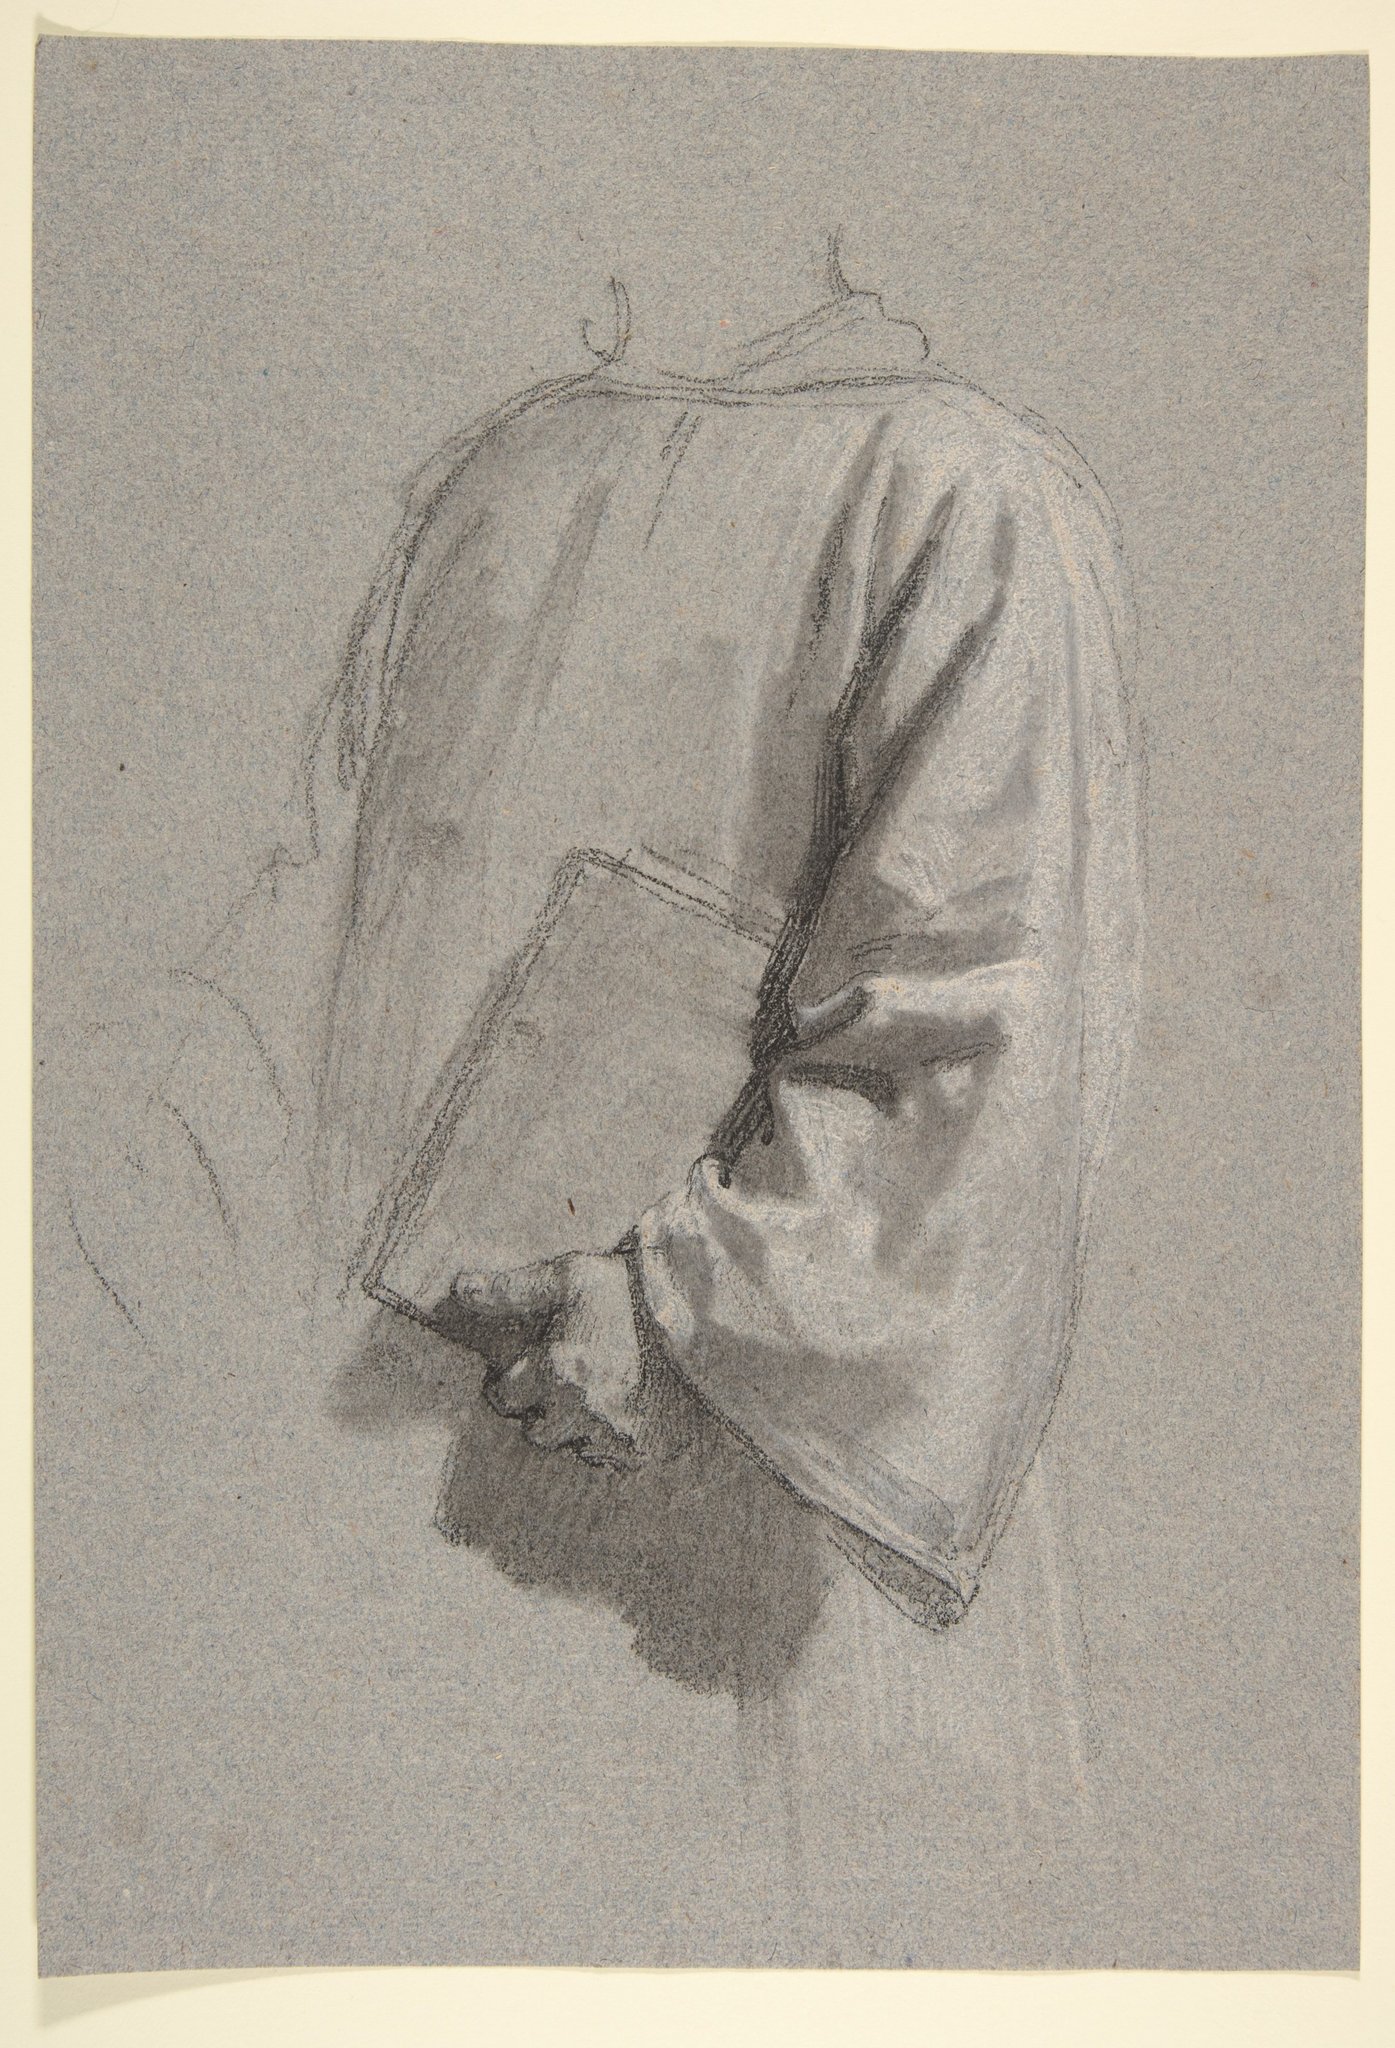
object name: drawing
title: Drapery Study for a Cleric (lower register; study for wall paintings in the Chapel of Saint Remi, Sainte-Clotilde, Paris, 1858)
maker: isidore pils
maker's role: artist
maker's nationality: french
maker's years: 1813-1875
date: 1801-1900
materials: chalk, paper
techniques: heightening, stumping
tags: hands,men